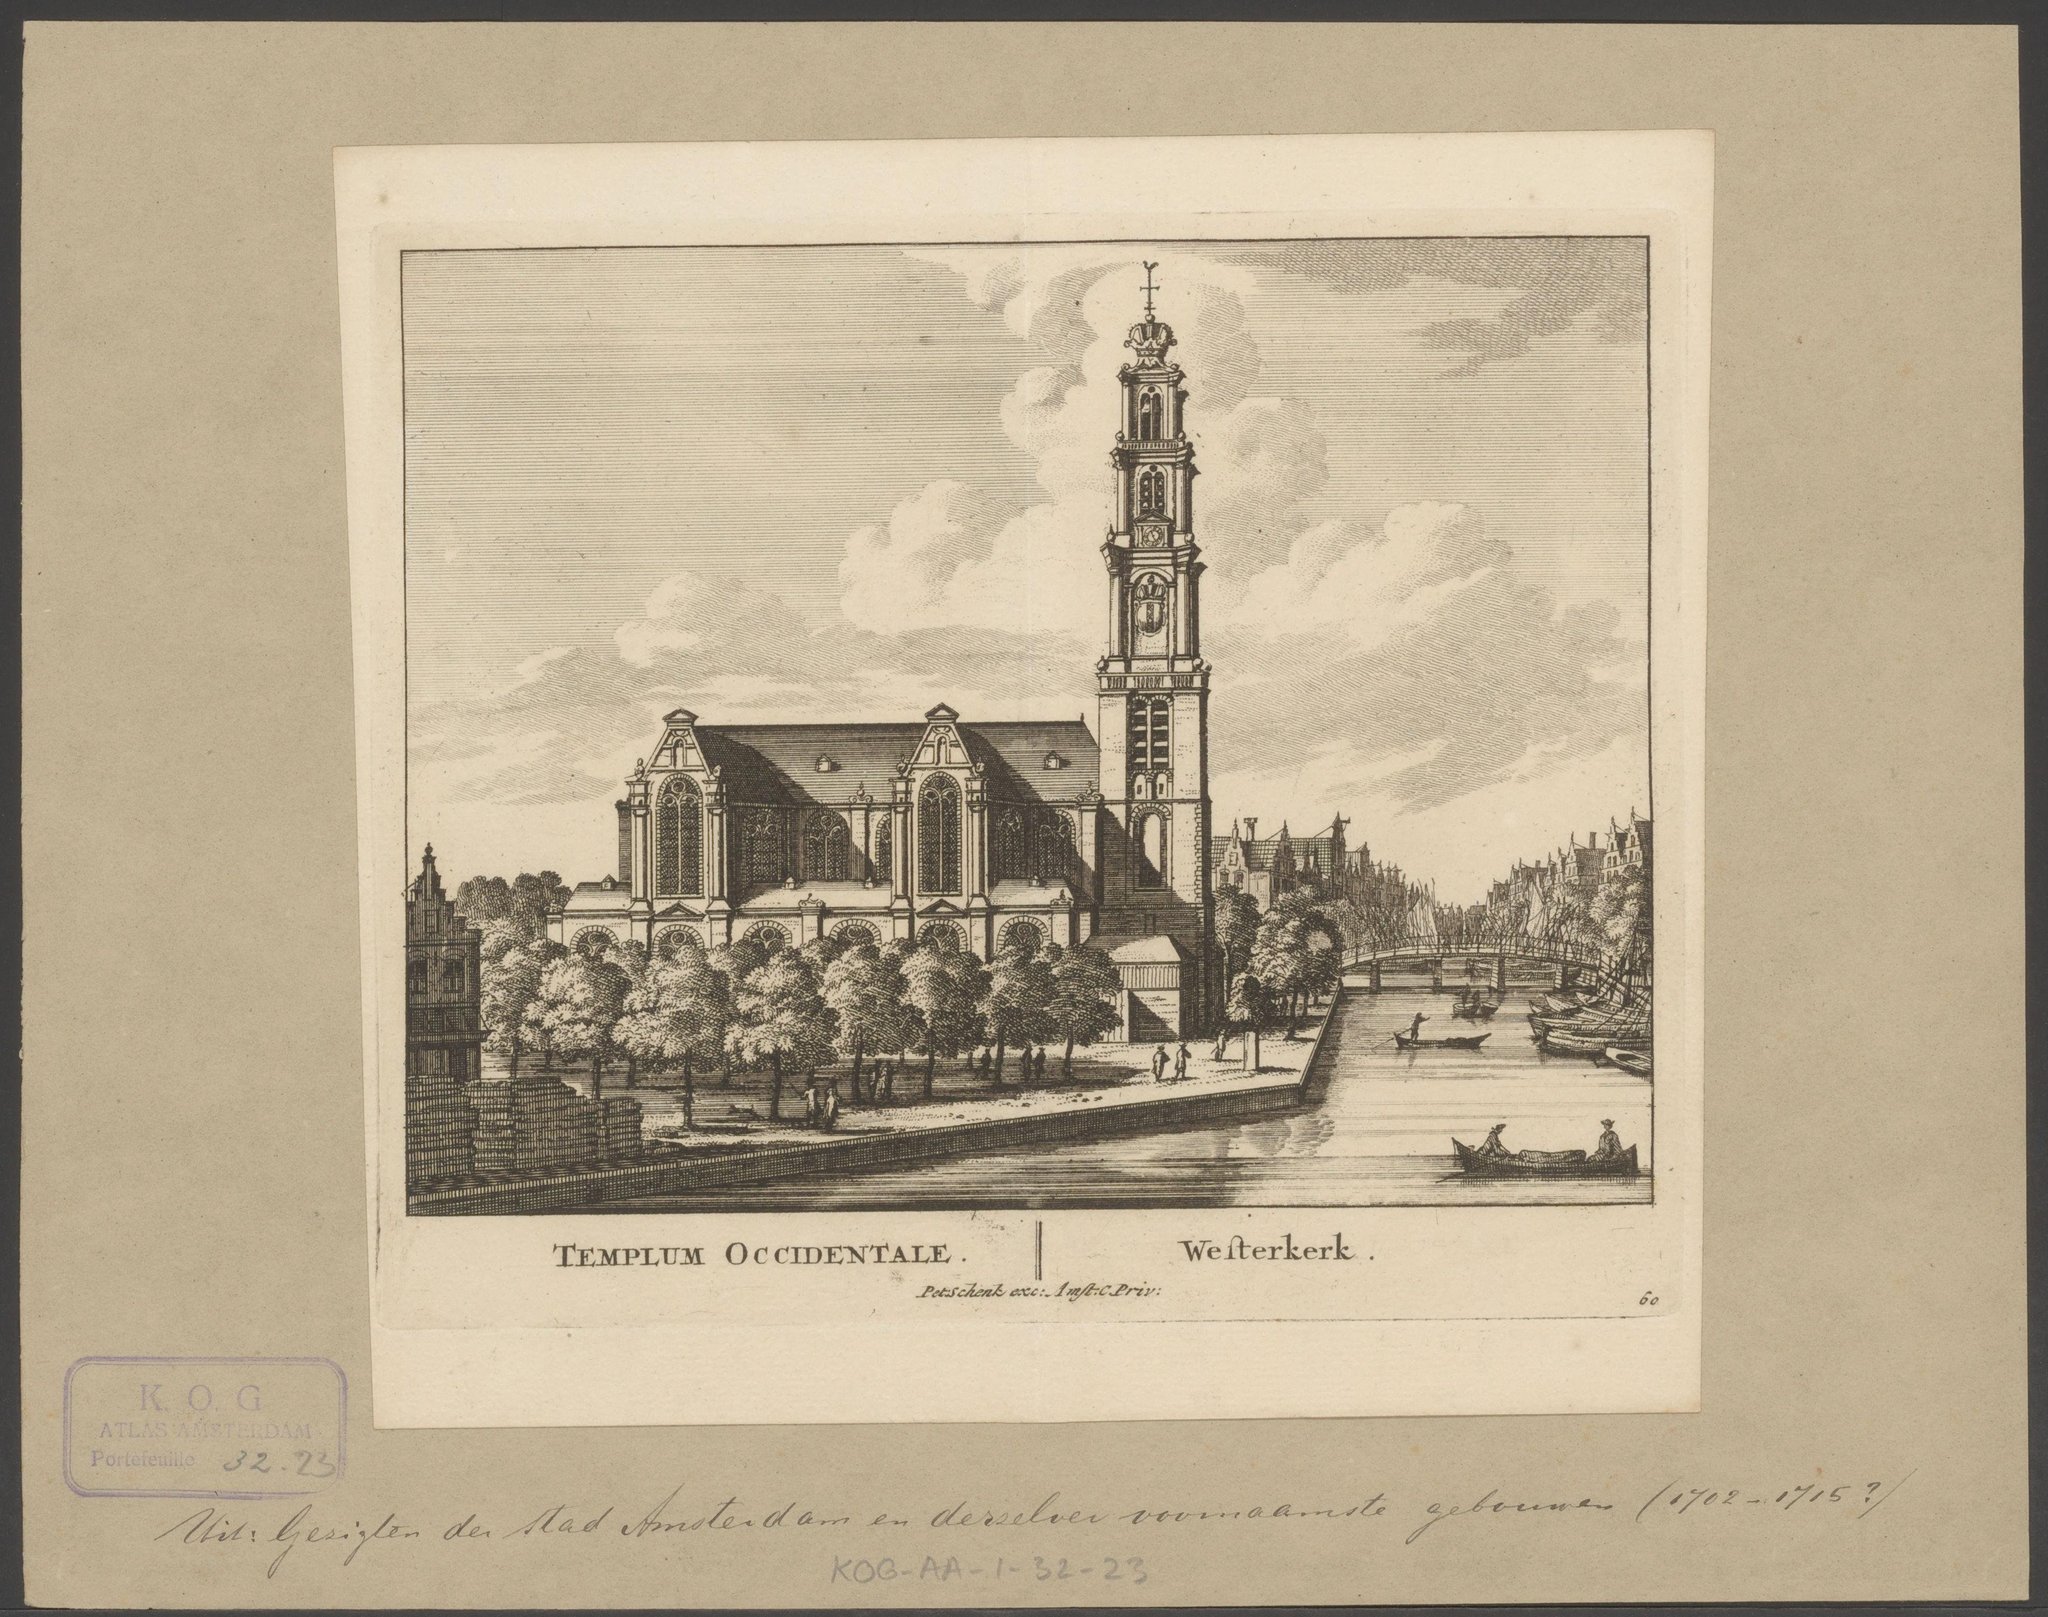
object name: book illustration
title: Templum Occidentale / WesterKerk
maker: Anonymous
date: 1710-1711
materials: paper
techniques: engraving, etching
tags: church (exterior), rowing-boat, canoe, etc., canals, waters (in city)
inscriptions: collector's mark: ‘32.23’ Lugt 1641b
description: Huidige staat van prent ook gebruikt in: 100 Afbeeldinge der voornaamste gebouwen van Amsterdam. Amsterdam, Pieter Schenk (I), s.a. [1710-1711]. En in: 100 Afbeeldinge der voornaamste gebouwen van Amsterdam. Amsterdam: Barent Greve, [1757-1766].* *In de tweede uitgave, uitgegeven door Barent Greve, is alleen de titelprent aangepast. De overige prenten zijn onveranderd gebleven.